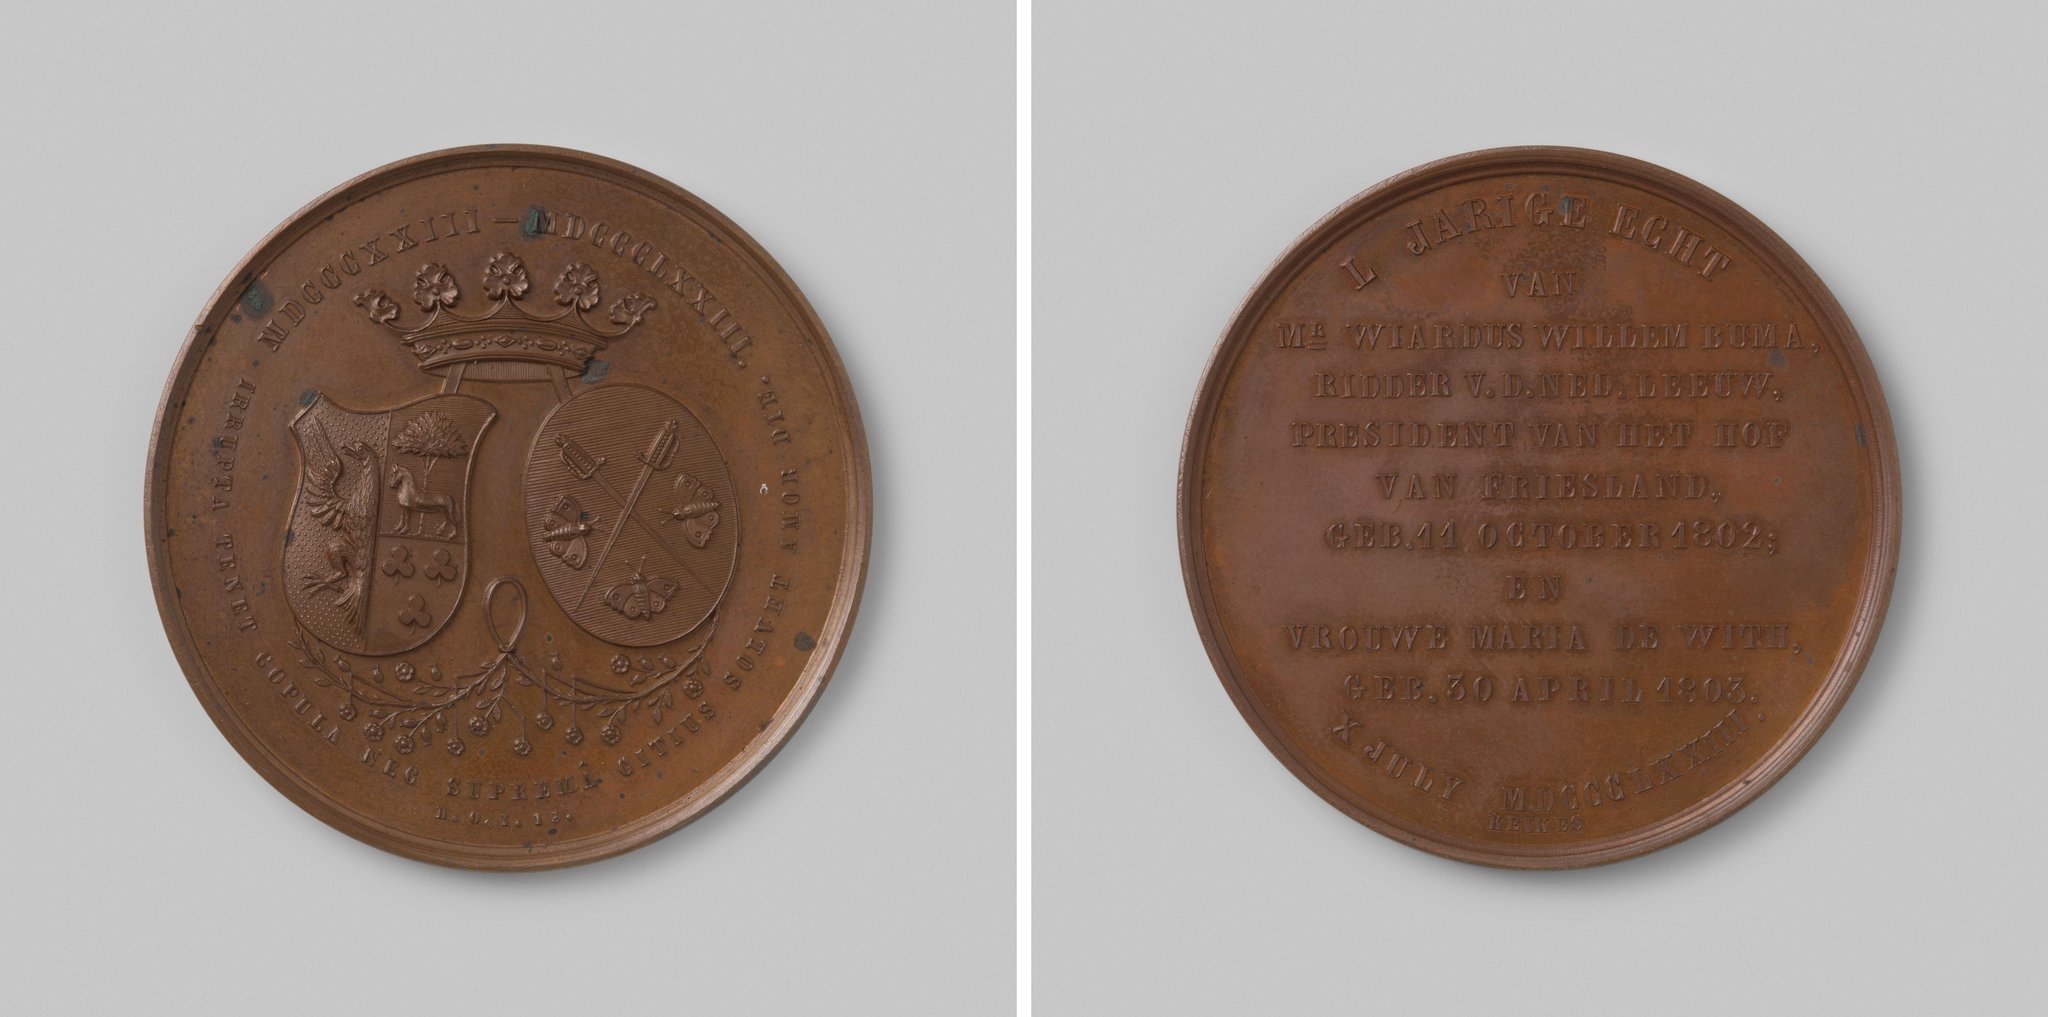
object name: family medal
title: Vijftigjarig huwelijk van Wiardus Willem Buma, raadsheer aan het Hof van Friesland en Maria de With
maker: tjeerd keikes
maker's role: medailleur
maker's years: 1804-1886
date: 1873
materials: bronze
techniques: striking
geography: leeuwarden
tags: maria de with, wiardus willem buma, hof van friesland, friesland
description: Bronzen penning. Voorzijde: twee wapenschilden aan lint onder kroon hangend boven takken van vergeet-mij-nietjes binnen omschrift. Keerzijde: opschrift binnen omschrift